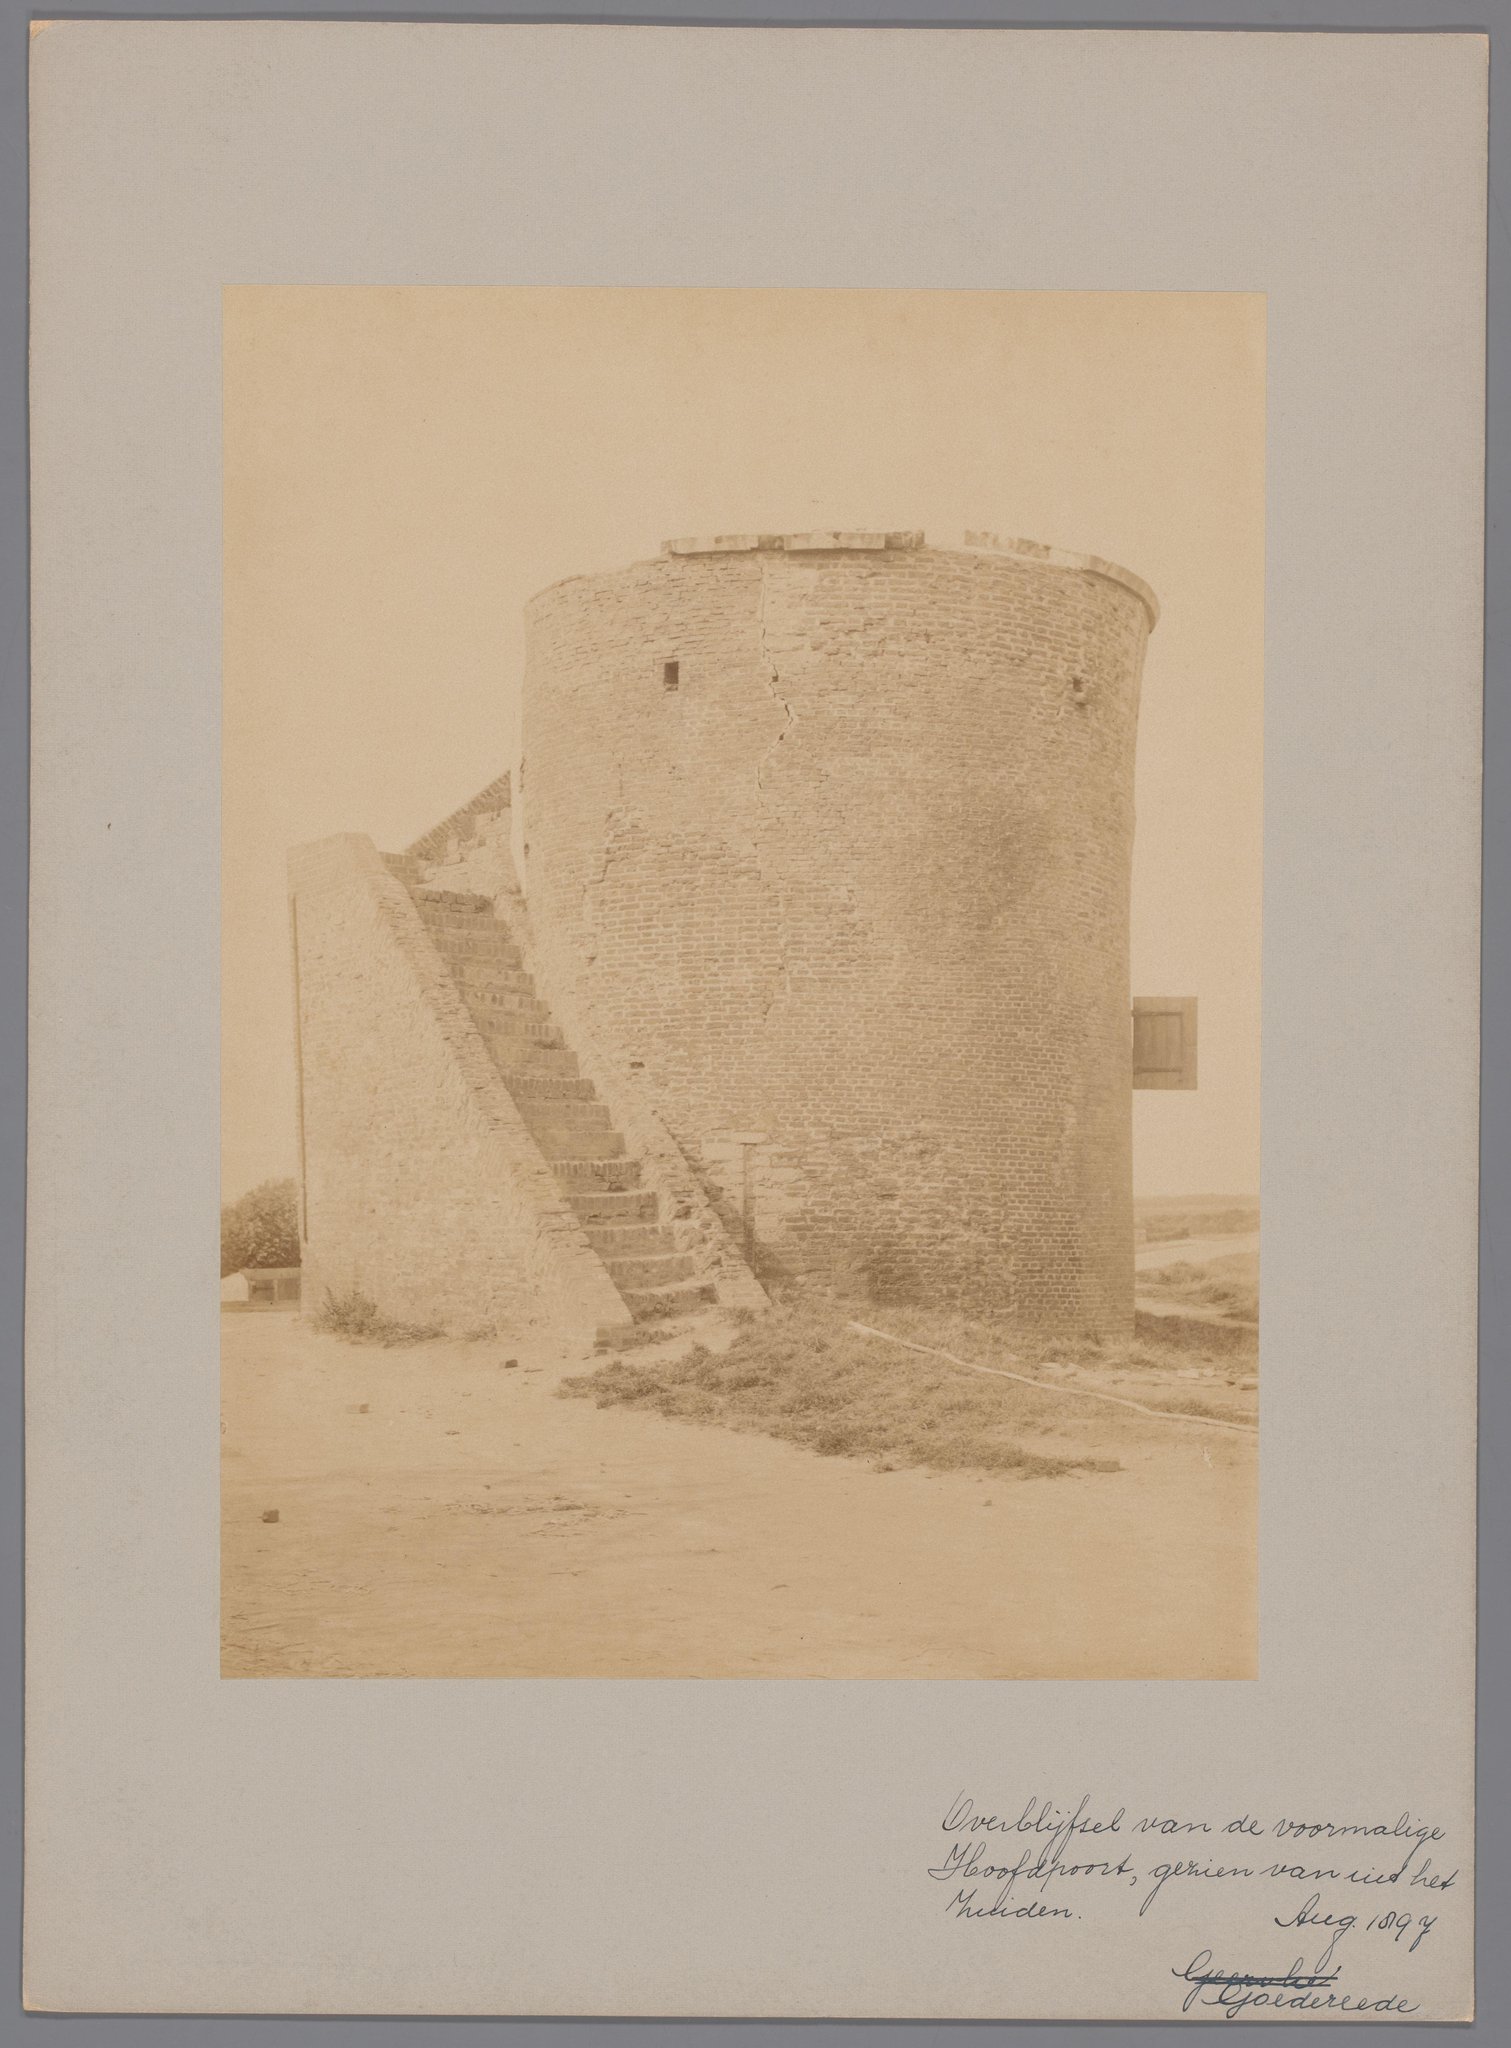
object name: photograph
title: Voormalige hoofdpoort van Goedereede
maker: anoniem (monumentenzorg)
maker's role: fotograaf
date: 1897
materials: cardboard, photographic support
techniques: albumen print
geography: goedereede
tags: gate, entrance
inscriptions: annotation: ‘Overblijfsel van de voormalige Hoofdpoort, gezien van uit het Zuiden/ Aug. 1897/ Goedereede’, annotation: ‘Goedereede (Z.H.)/ overblijfsel van de voormalige hoofdpoort gezien van uit het zuiden/ Aug 1897’